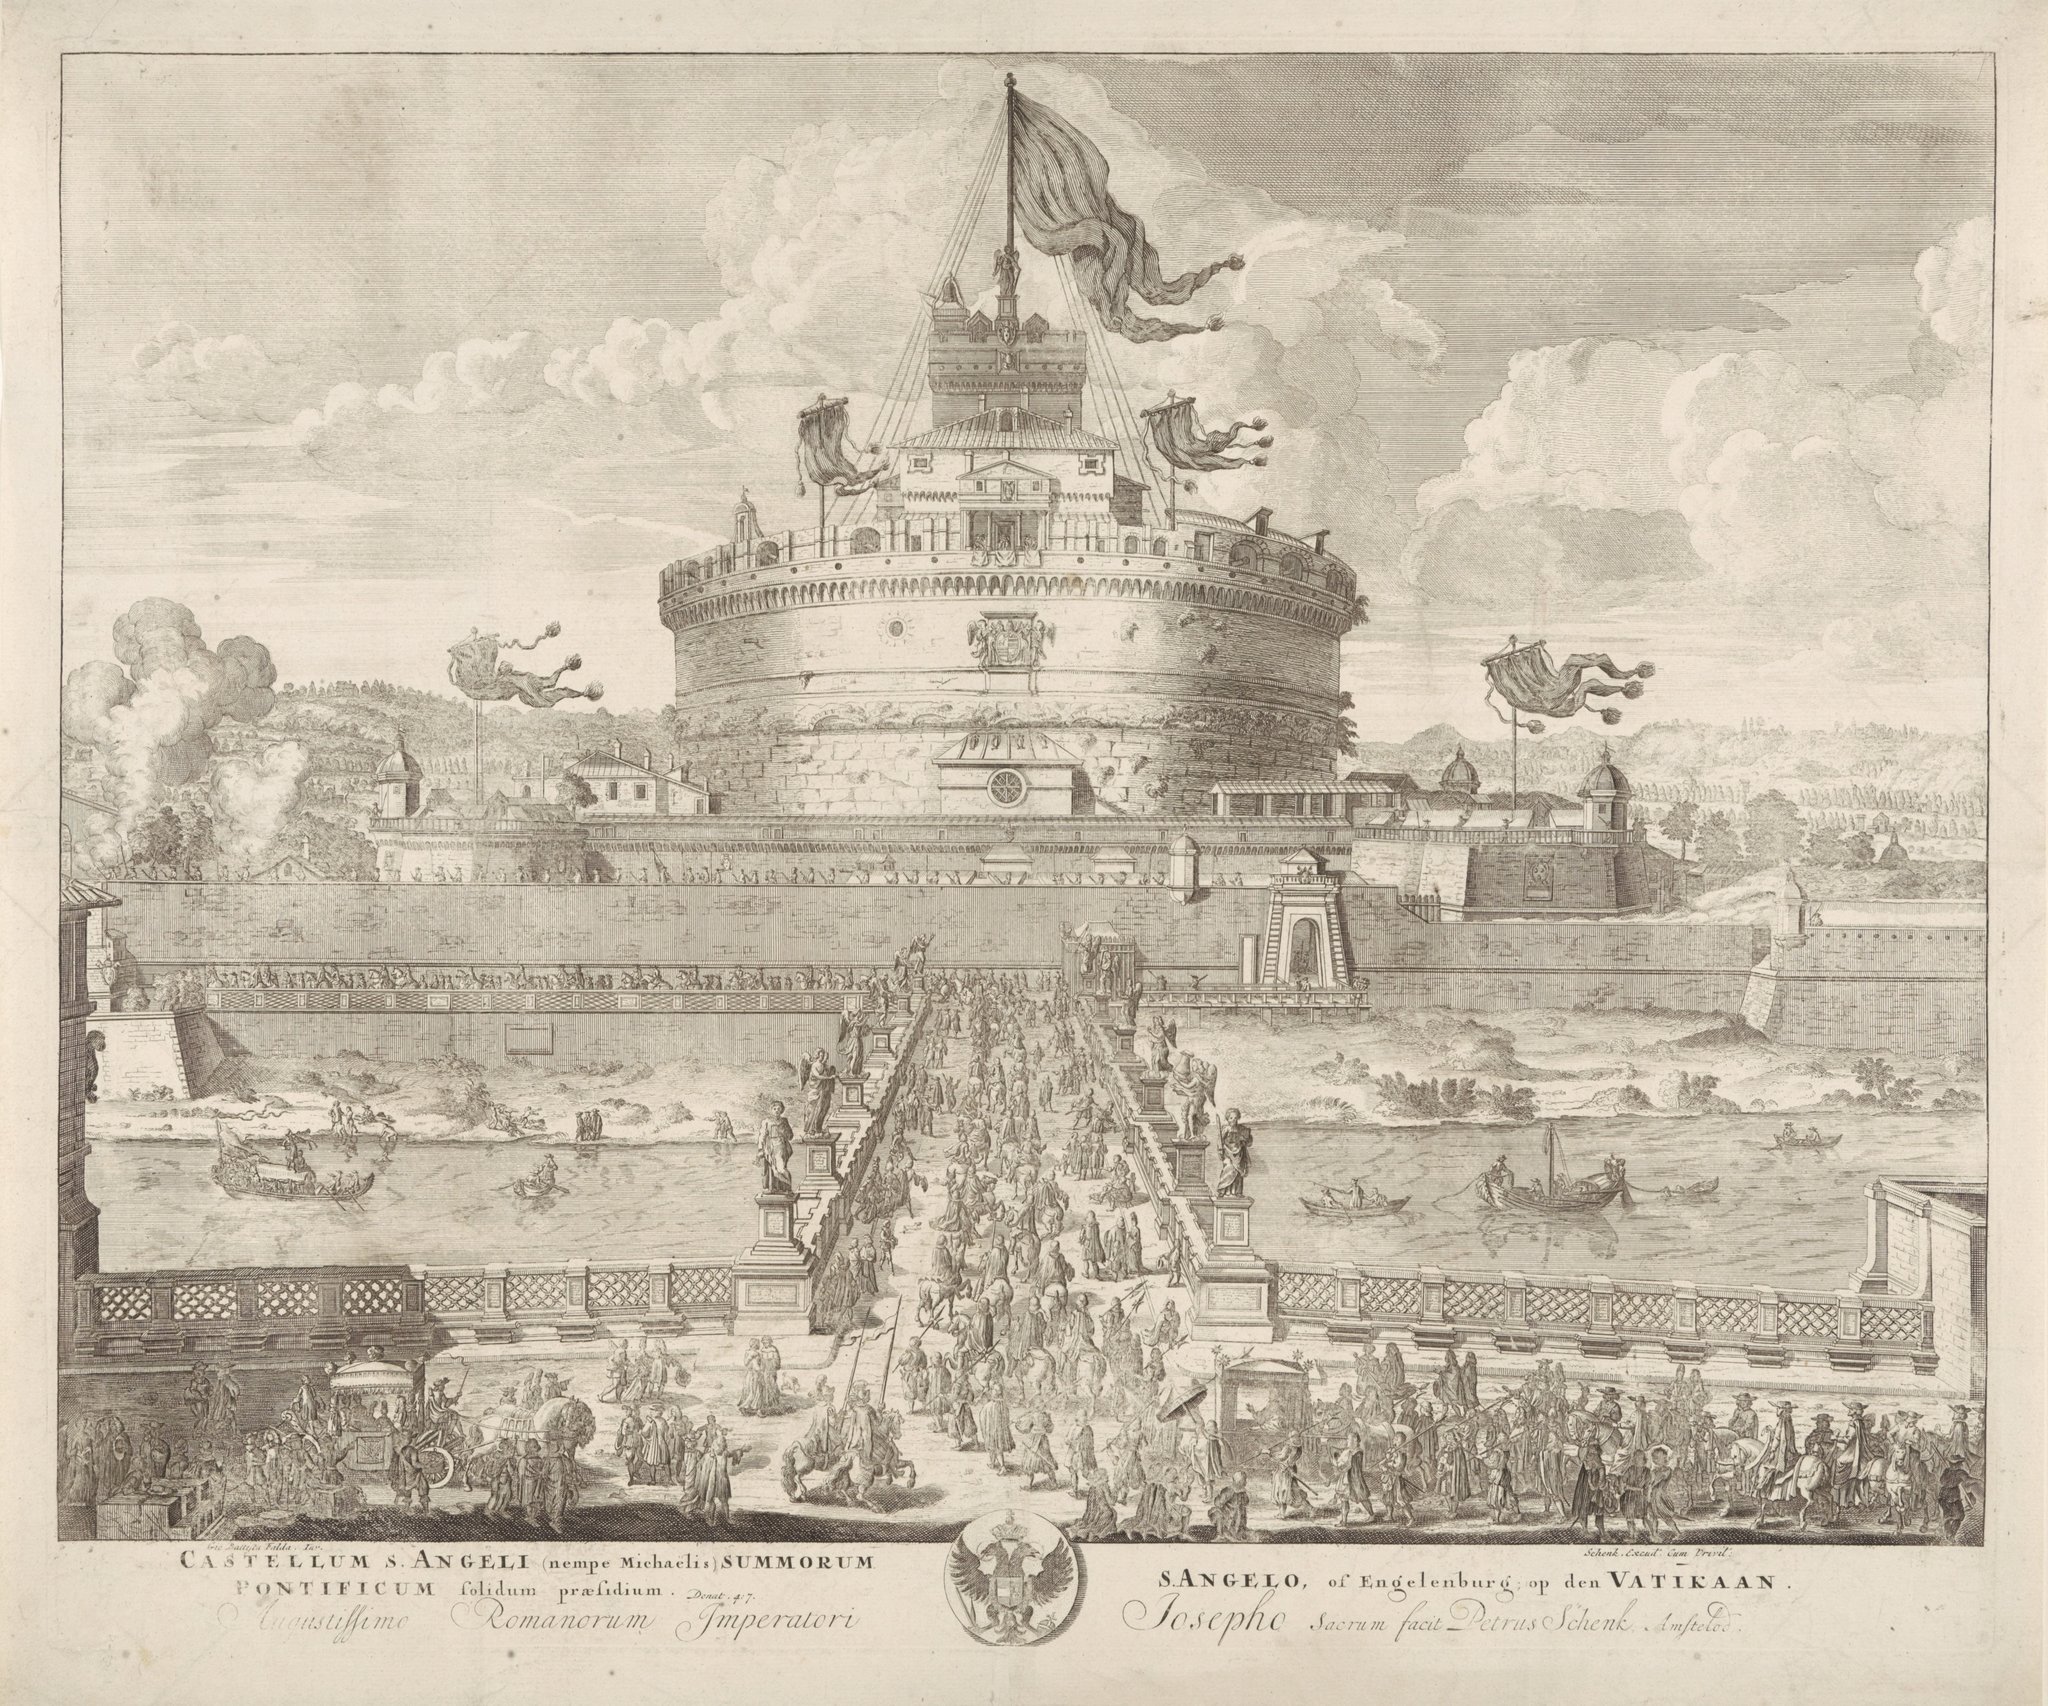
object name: print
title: Castellum S. Angeli (nempe Michaelis) Summorum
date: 1675-1712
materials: paper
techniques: engraving, etching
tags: engelenburcht, engelenbrug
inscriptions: collector's mark: Lugt 2228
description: Gezicht op de Engelenburcht, in het Italiaans 'Castel Sant' Angelo' genoemd, te Rome. Op de voorgrond trekt een stoet van geestelijken, edellieden en andere figuren over de Engelenbrug richting de Engelenburcht.